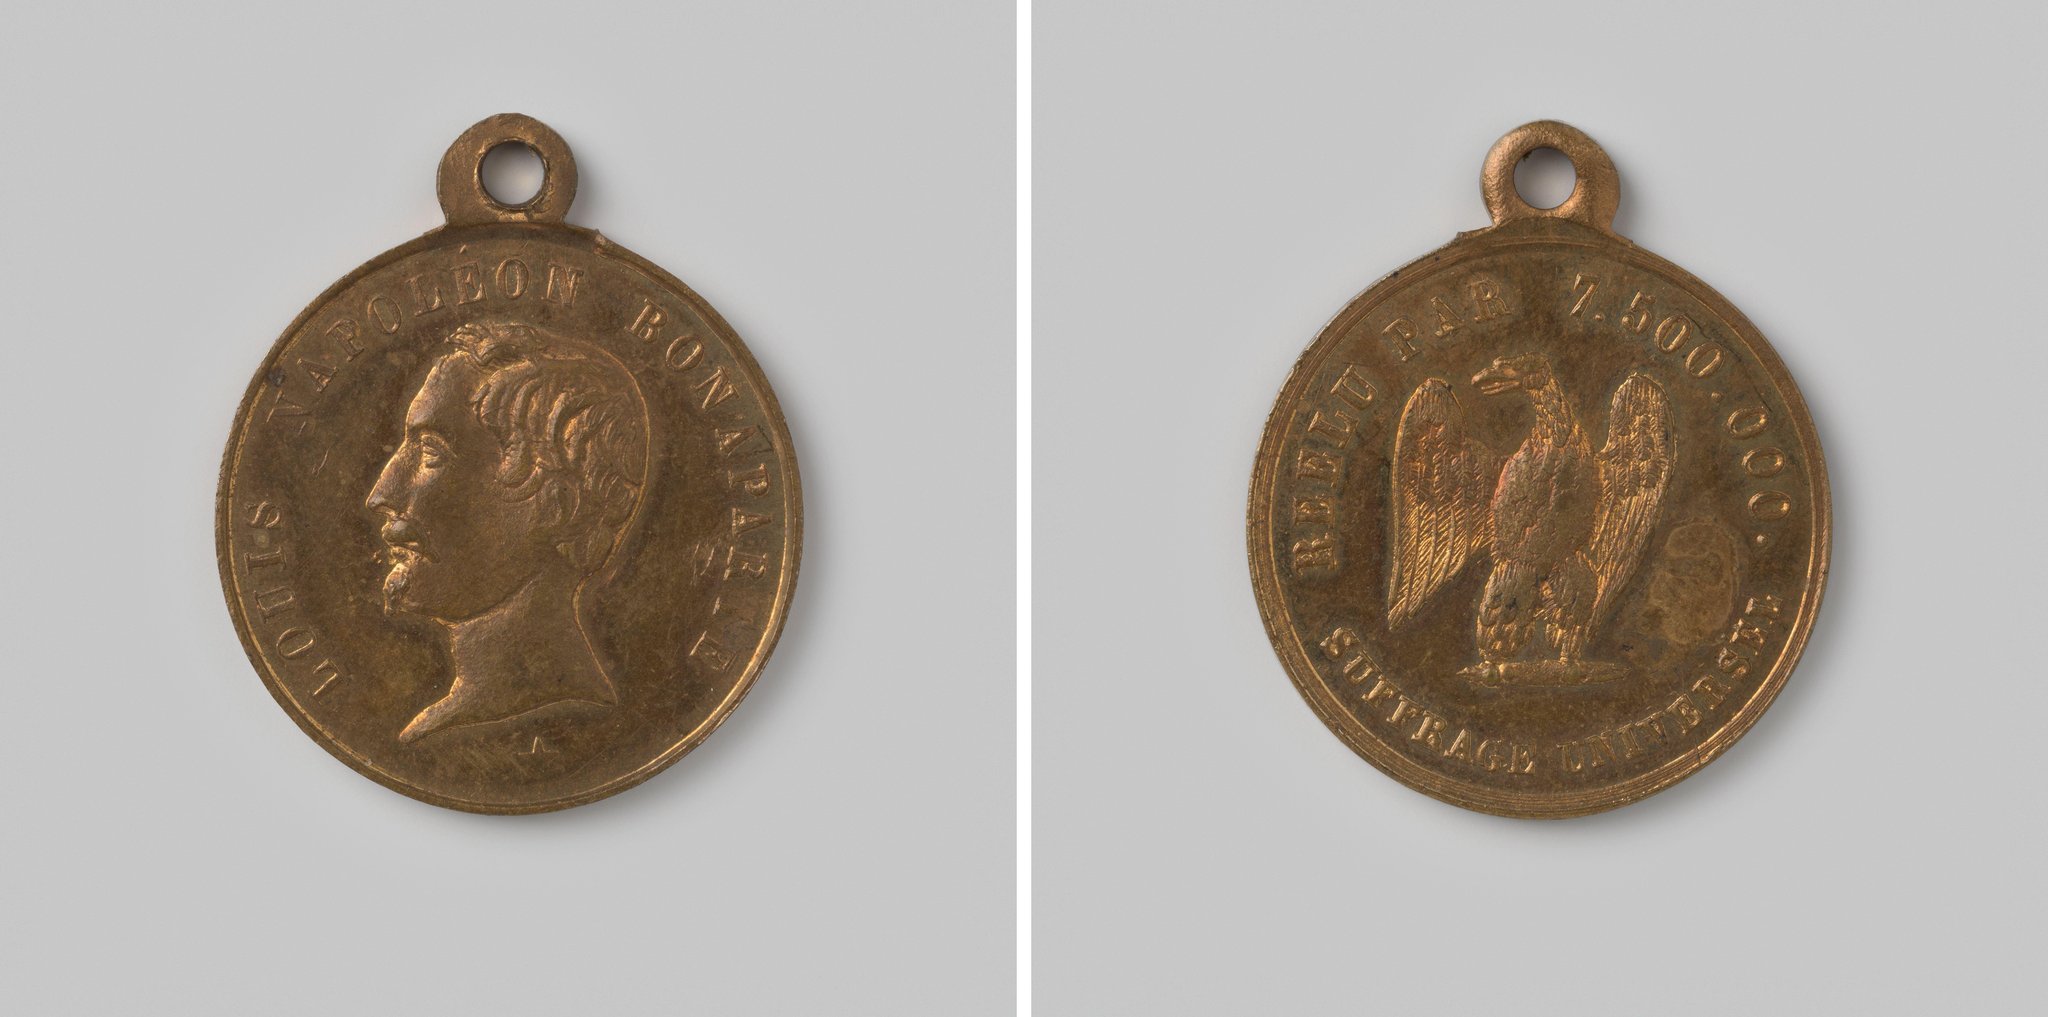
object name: history medal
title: Verkiezing van president Louis Napoleon Bonaparte tot Keizer 1851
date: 1851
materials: brass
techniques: striking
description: Messing penning met draagoog, op de voorzijde het portret van Bonaparte naar links met omschrift, op de keerzijde een adelaar staand op een bliksemschicht, met omschrift.